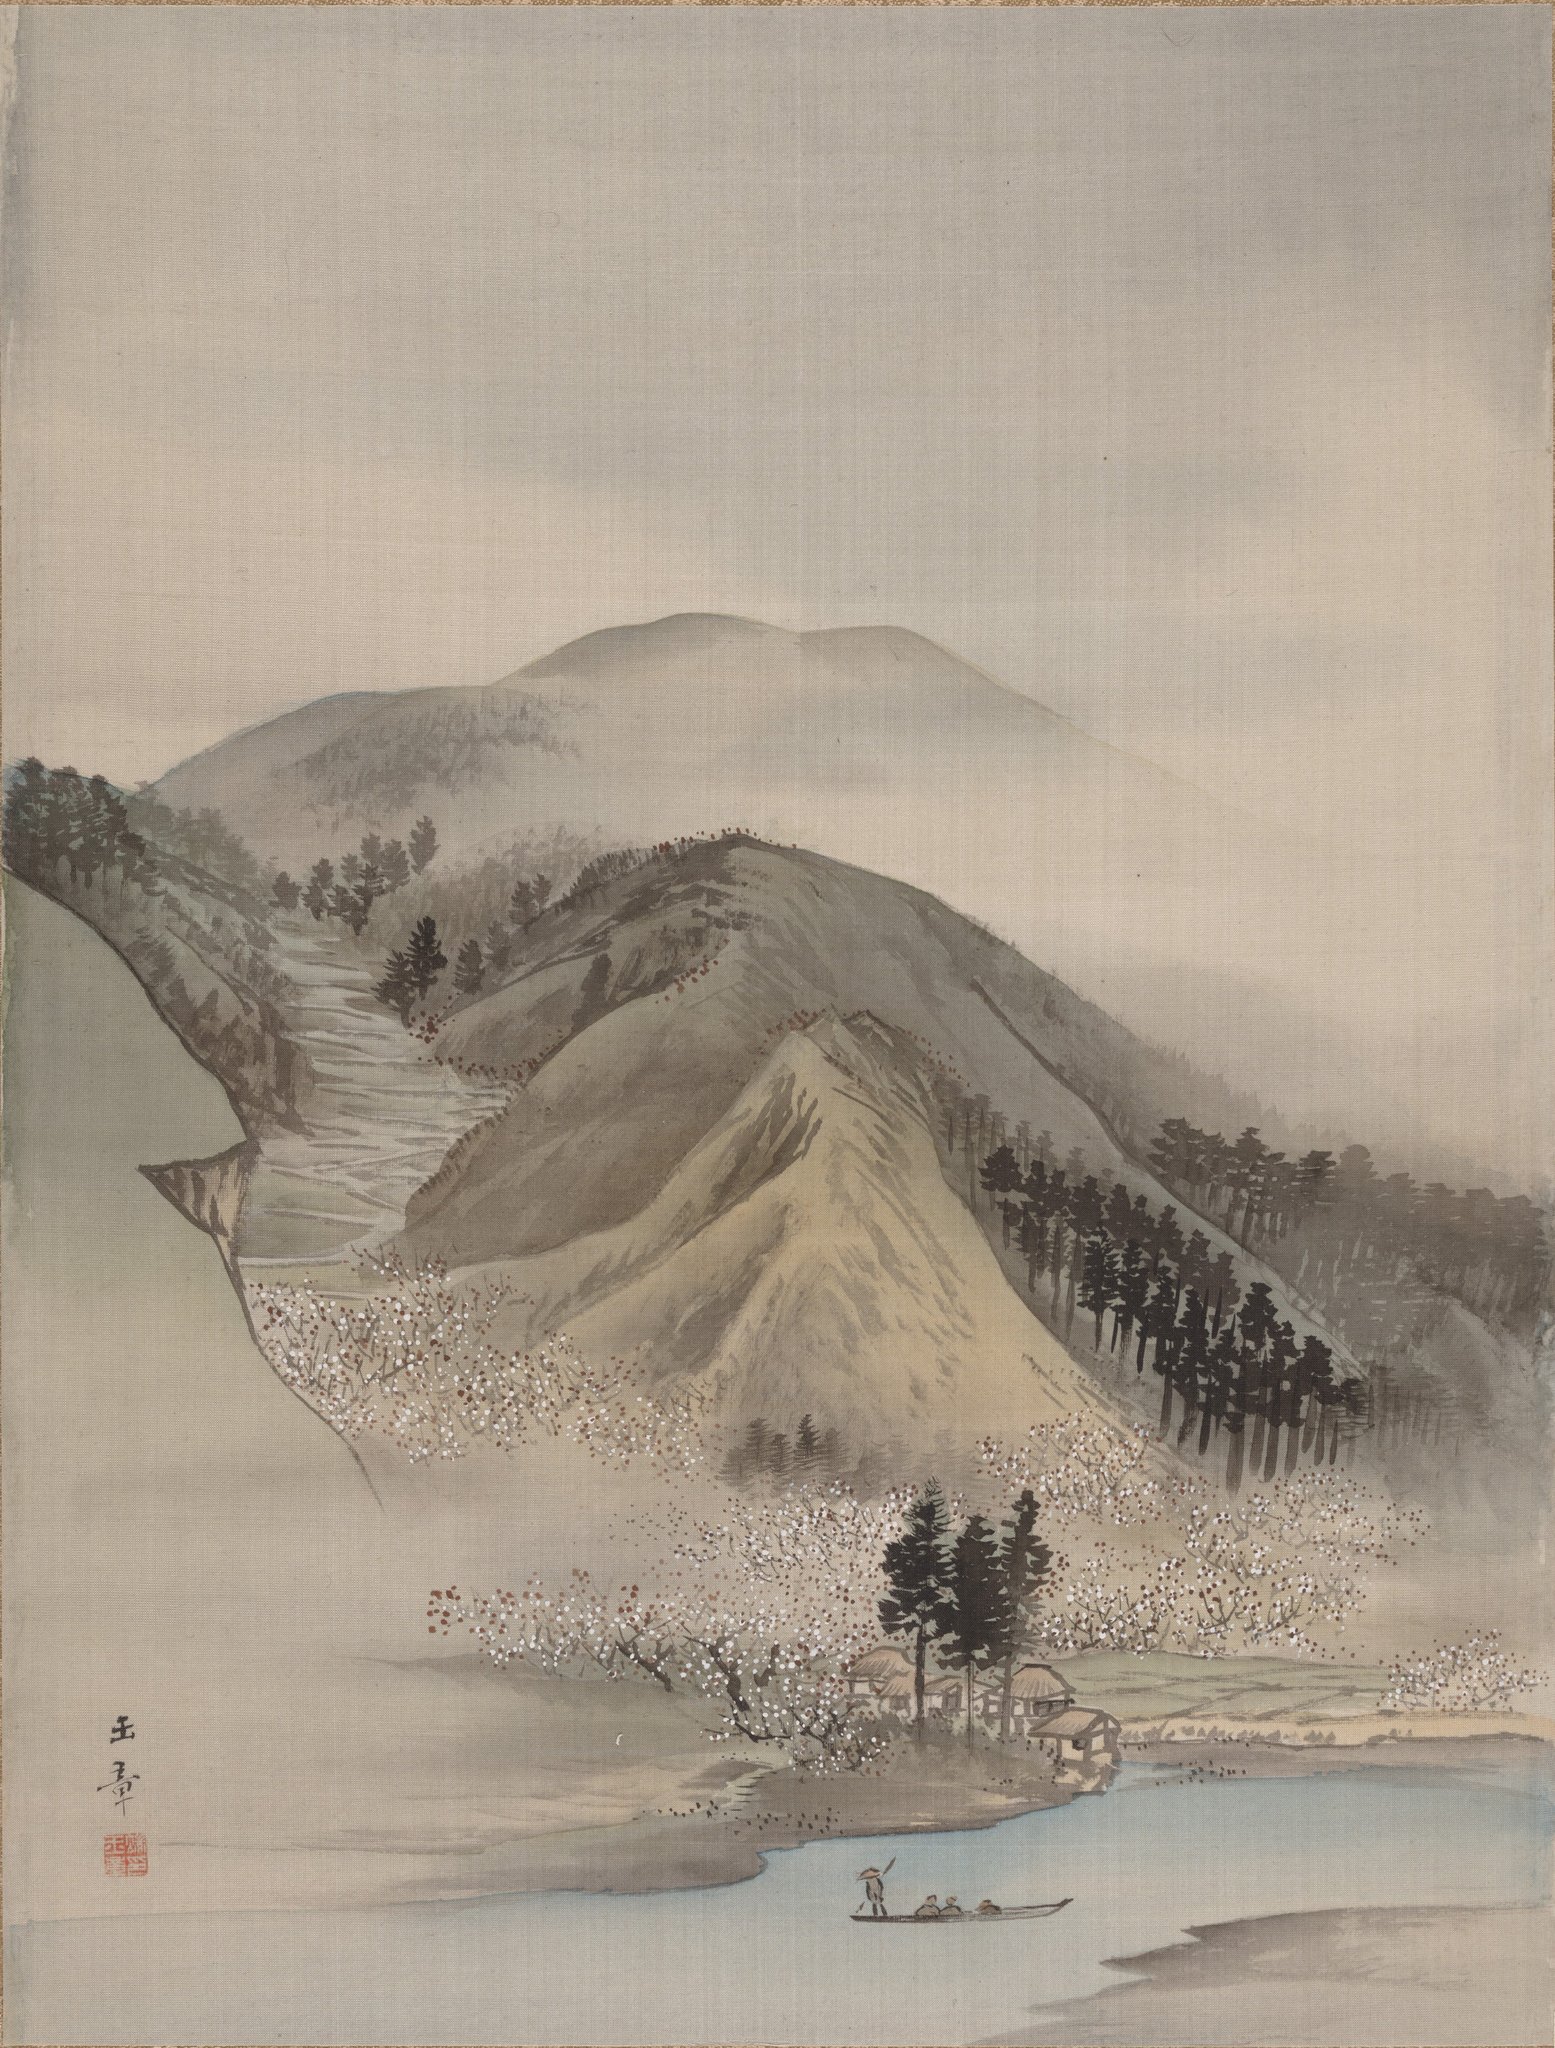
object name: album leaf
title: Blossoms by a River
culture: japanese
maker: kawabata gyokushō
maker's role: artist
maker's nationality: japanese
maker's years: 1842-1913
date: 1887-1892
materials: ink, silk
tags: rivers,mountains,landscapes,boats